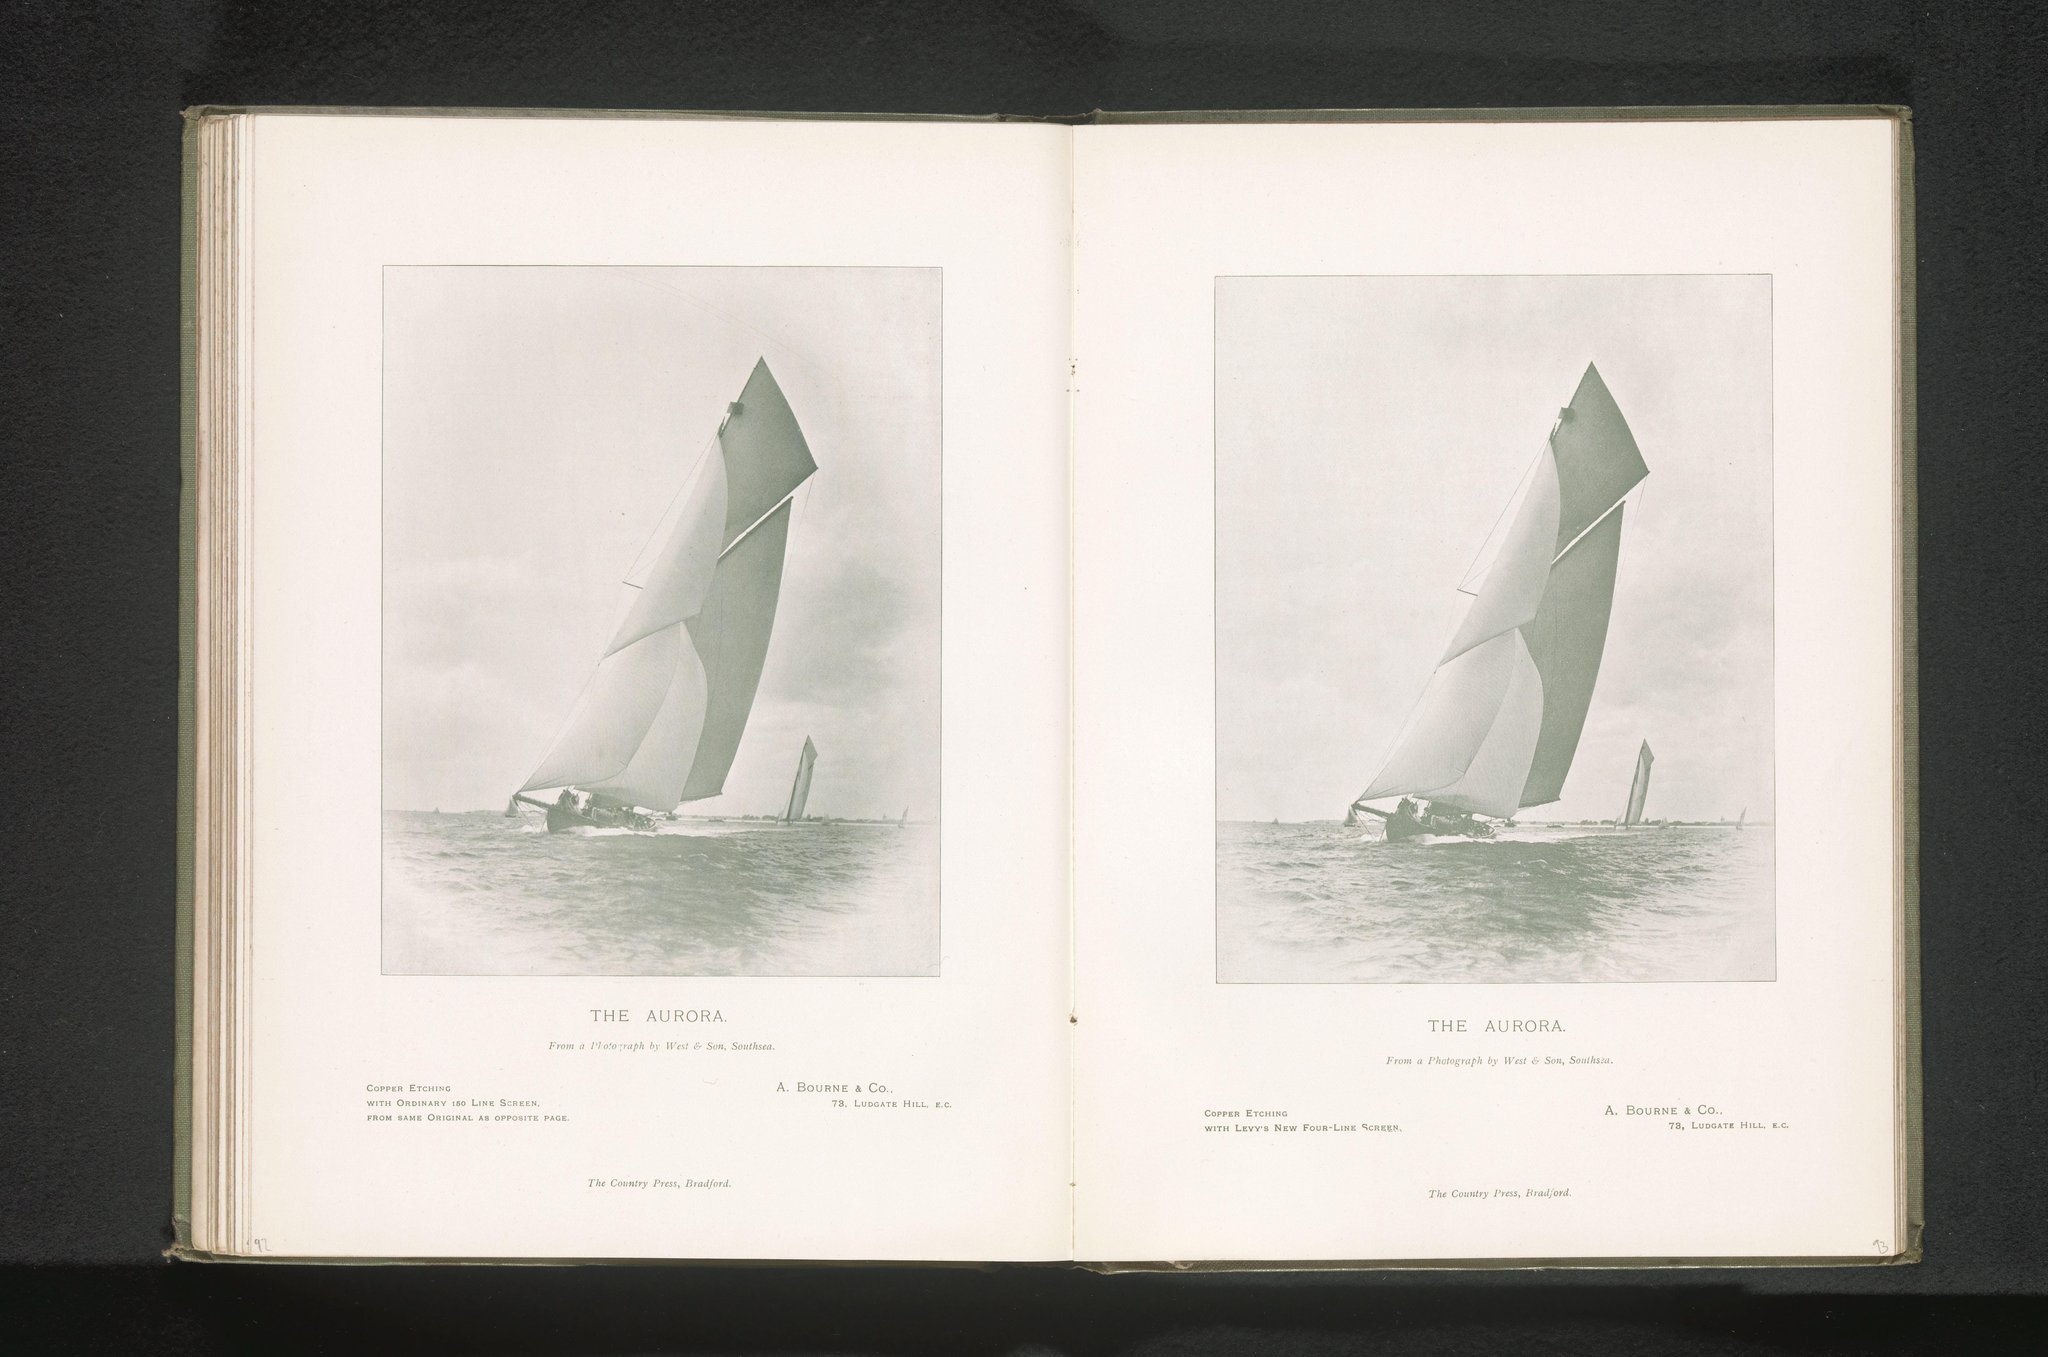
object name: page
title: The Aurora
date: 1893-1898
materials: paper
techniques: autotype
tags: sailing-ship, sailing-boat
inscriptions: inscription: ‘Copper Etching/ with Ordinary 150 Line Screen, from same Original as opposite page.’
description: Prent op tweede ongenummerde pagina na pagina 108.